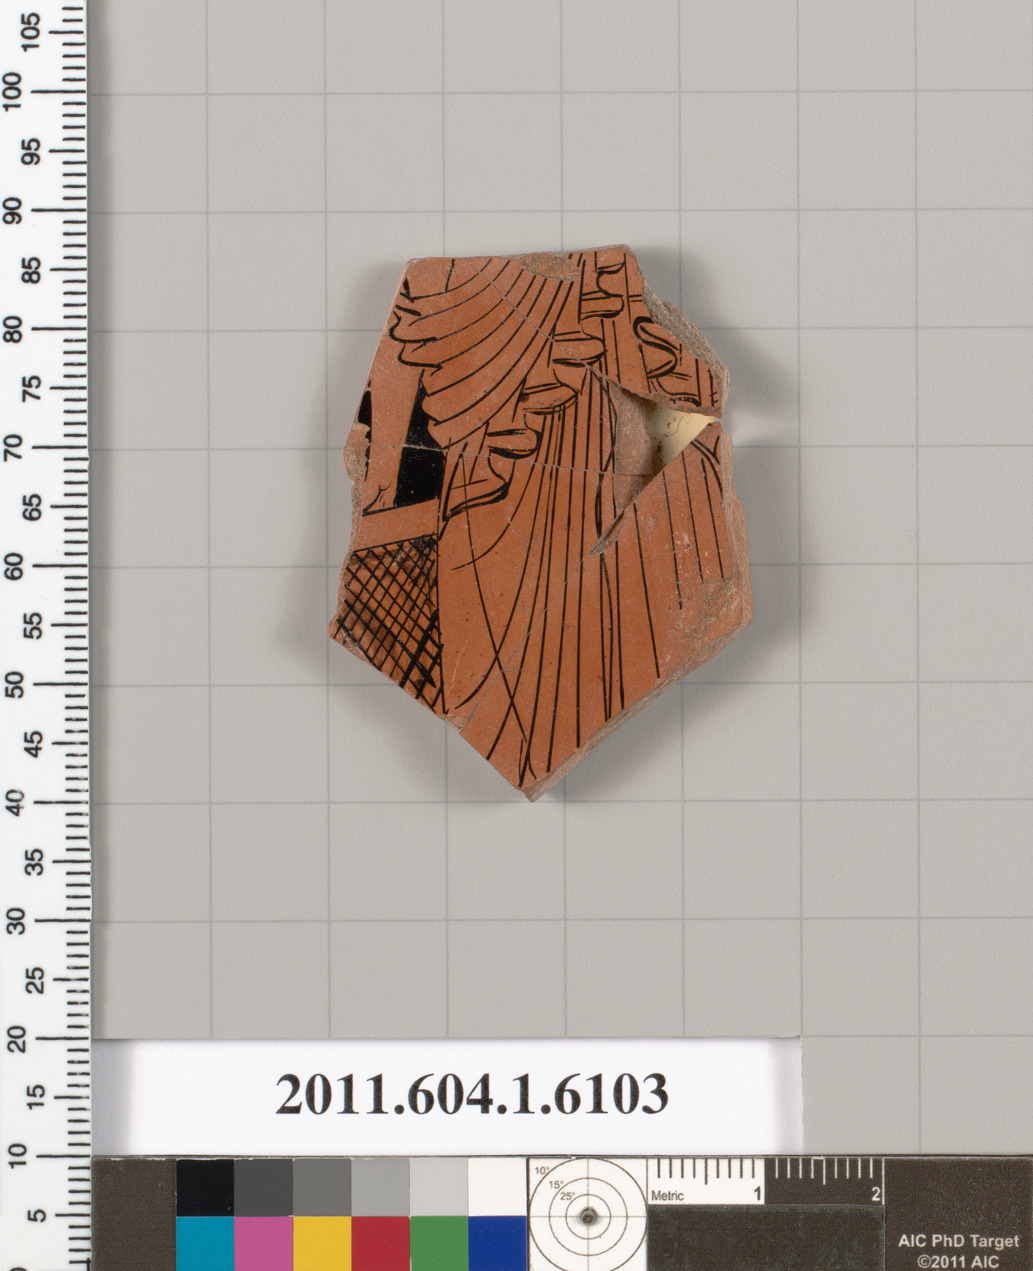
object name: kylix fragment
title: Terracotta fragment of a kylix (drinking cup)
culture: greek, attic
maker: apollodoros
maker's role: artist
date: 500-490 BCE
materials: terracotta